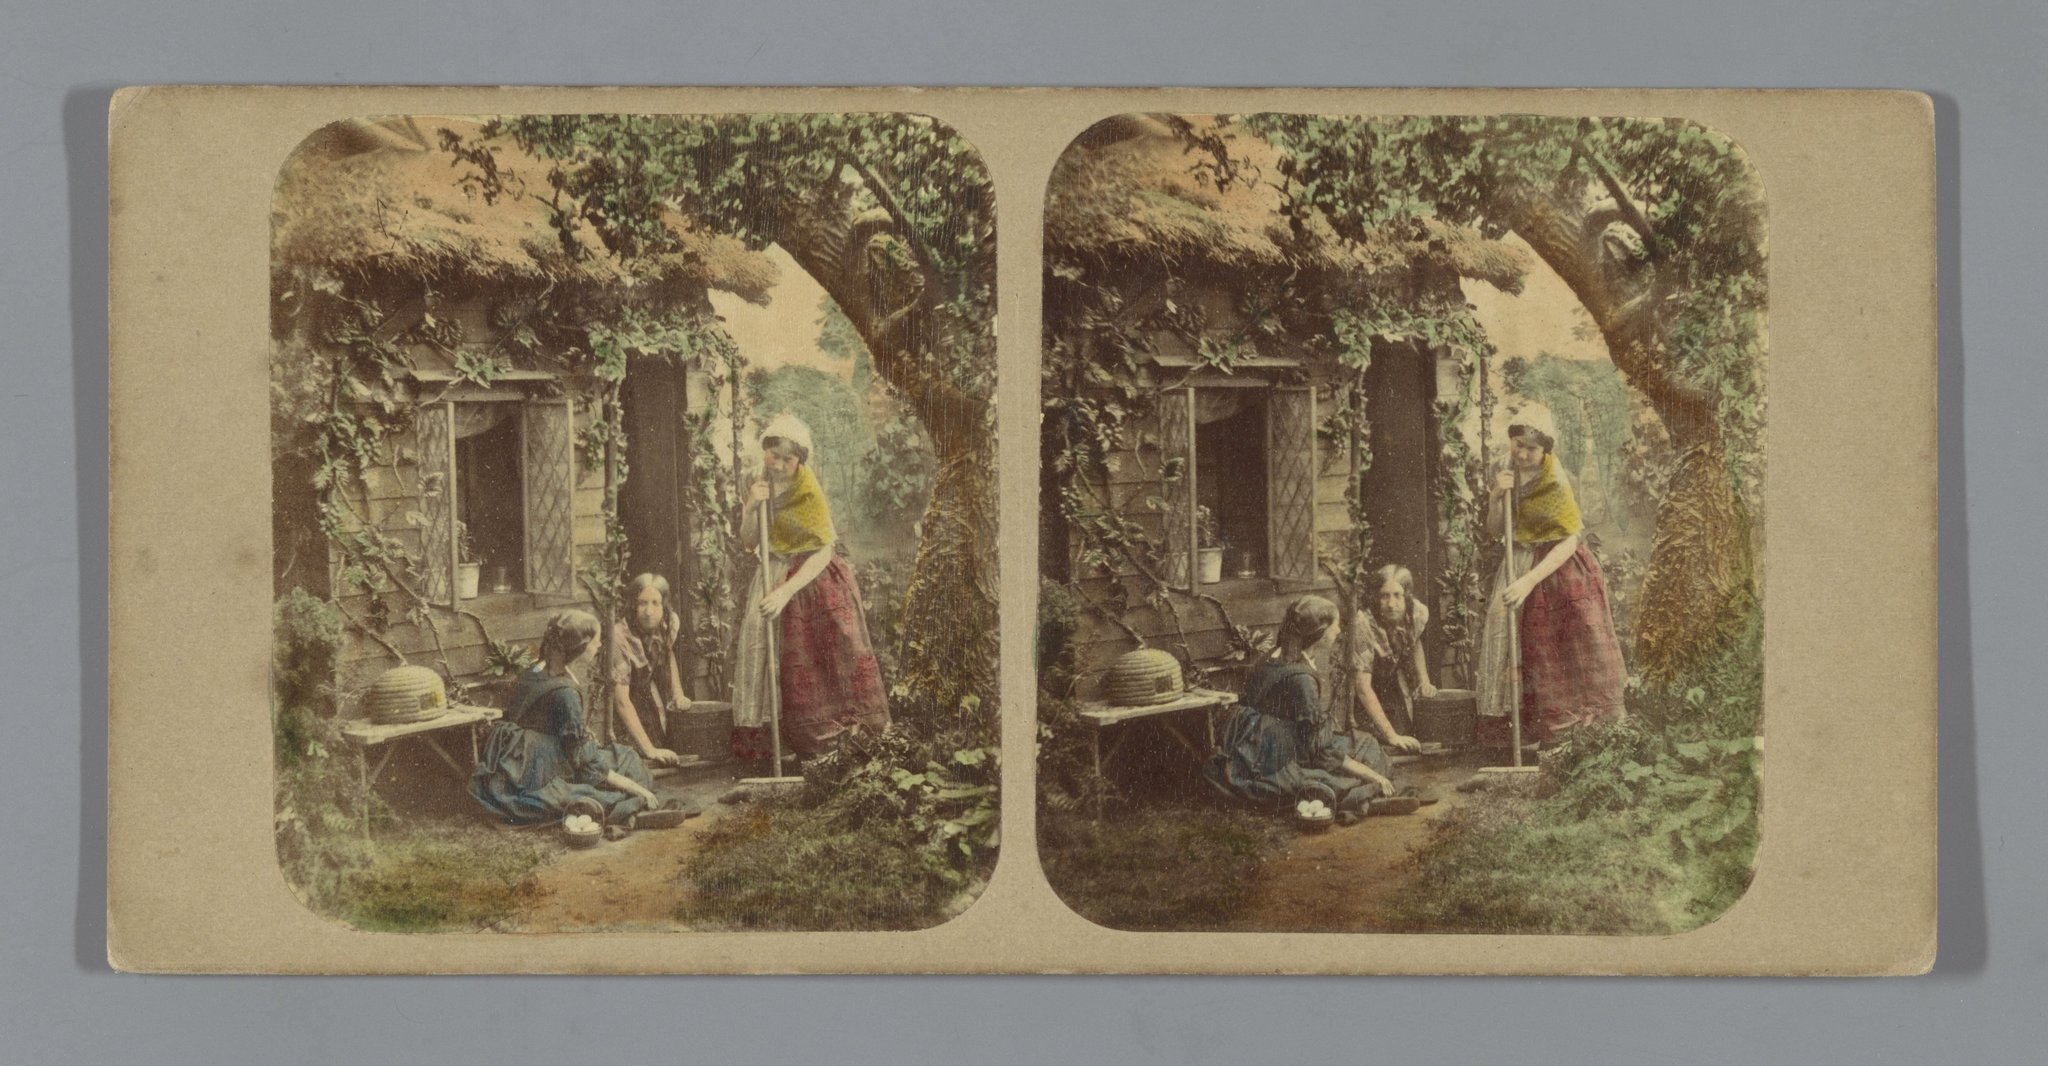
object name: stereograph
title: Drie vrouwen voor een cottage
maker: Anonymous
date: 1852-1863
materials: cardboard, paper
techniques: albumen print, hand coloring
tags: cottage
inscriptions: number: ‘16’, stamp: ‘J. C. MEERBURG,/ LEIJDEN’